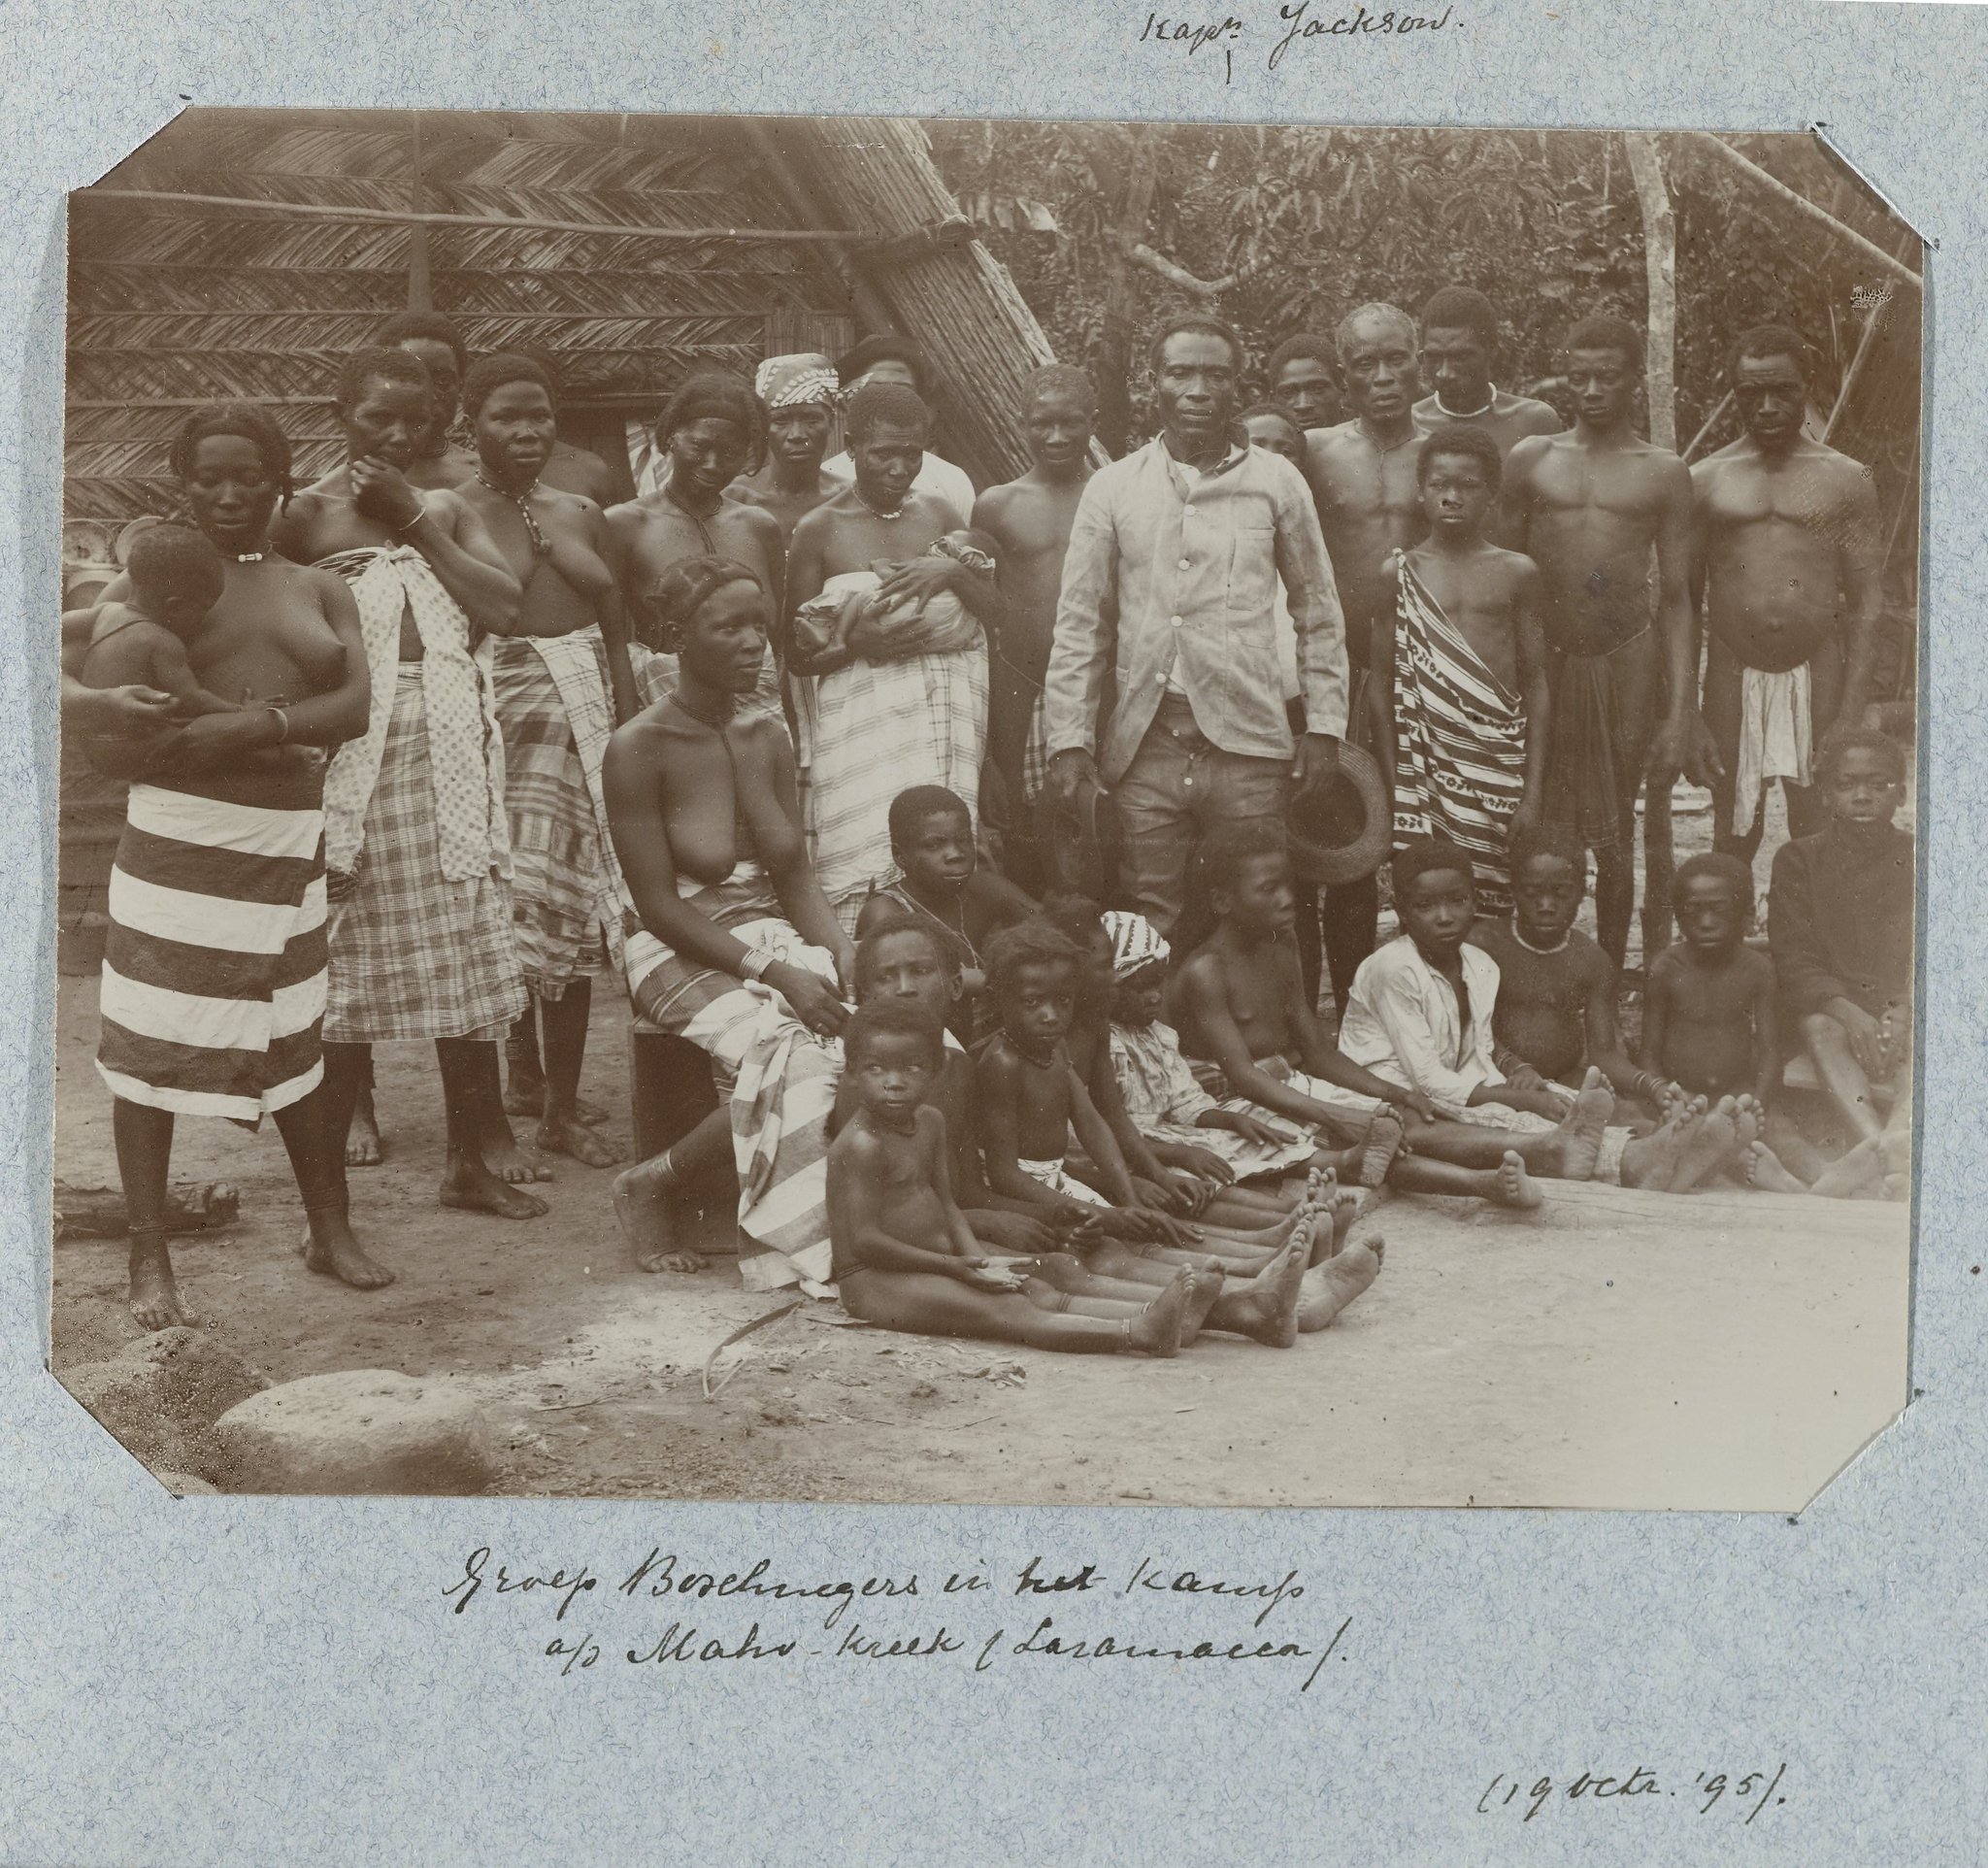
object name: photograph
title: Groep Saramaccaner Marrons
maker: théodore van lelyveld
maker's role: painter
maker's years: 1867-1954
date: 1895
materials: photographic support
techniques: collodion silver print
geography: suriname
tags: public road in village (+ city(-scape) with figures, staffage), suriname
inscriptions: inscription: ‘Groep Boschnegers in het kamp a/d Maho-kreek (Saramacca) (19 octr. '95) / Kapt. Jackson’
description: Een groep bosnegers in een dorp aan de Saramacca. Centraal de kapitein Jackson. Fotoafdruk in een fotoalbum van Théodore van Lelyveld over Suriname uit 1895-1898.